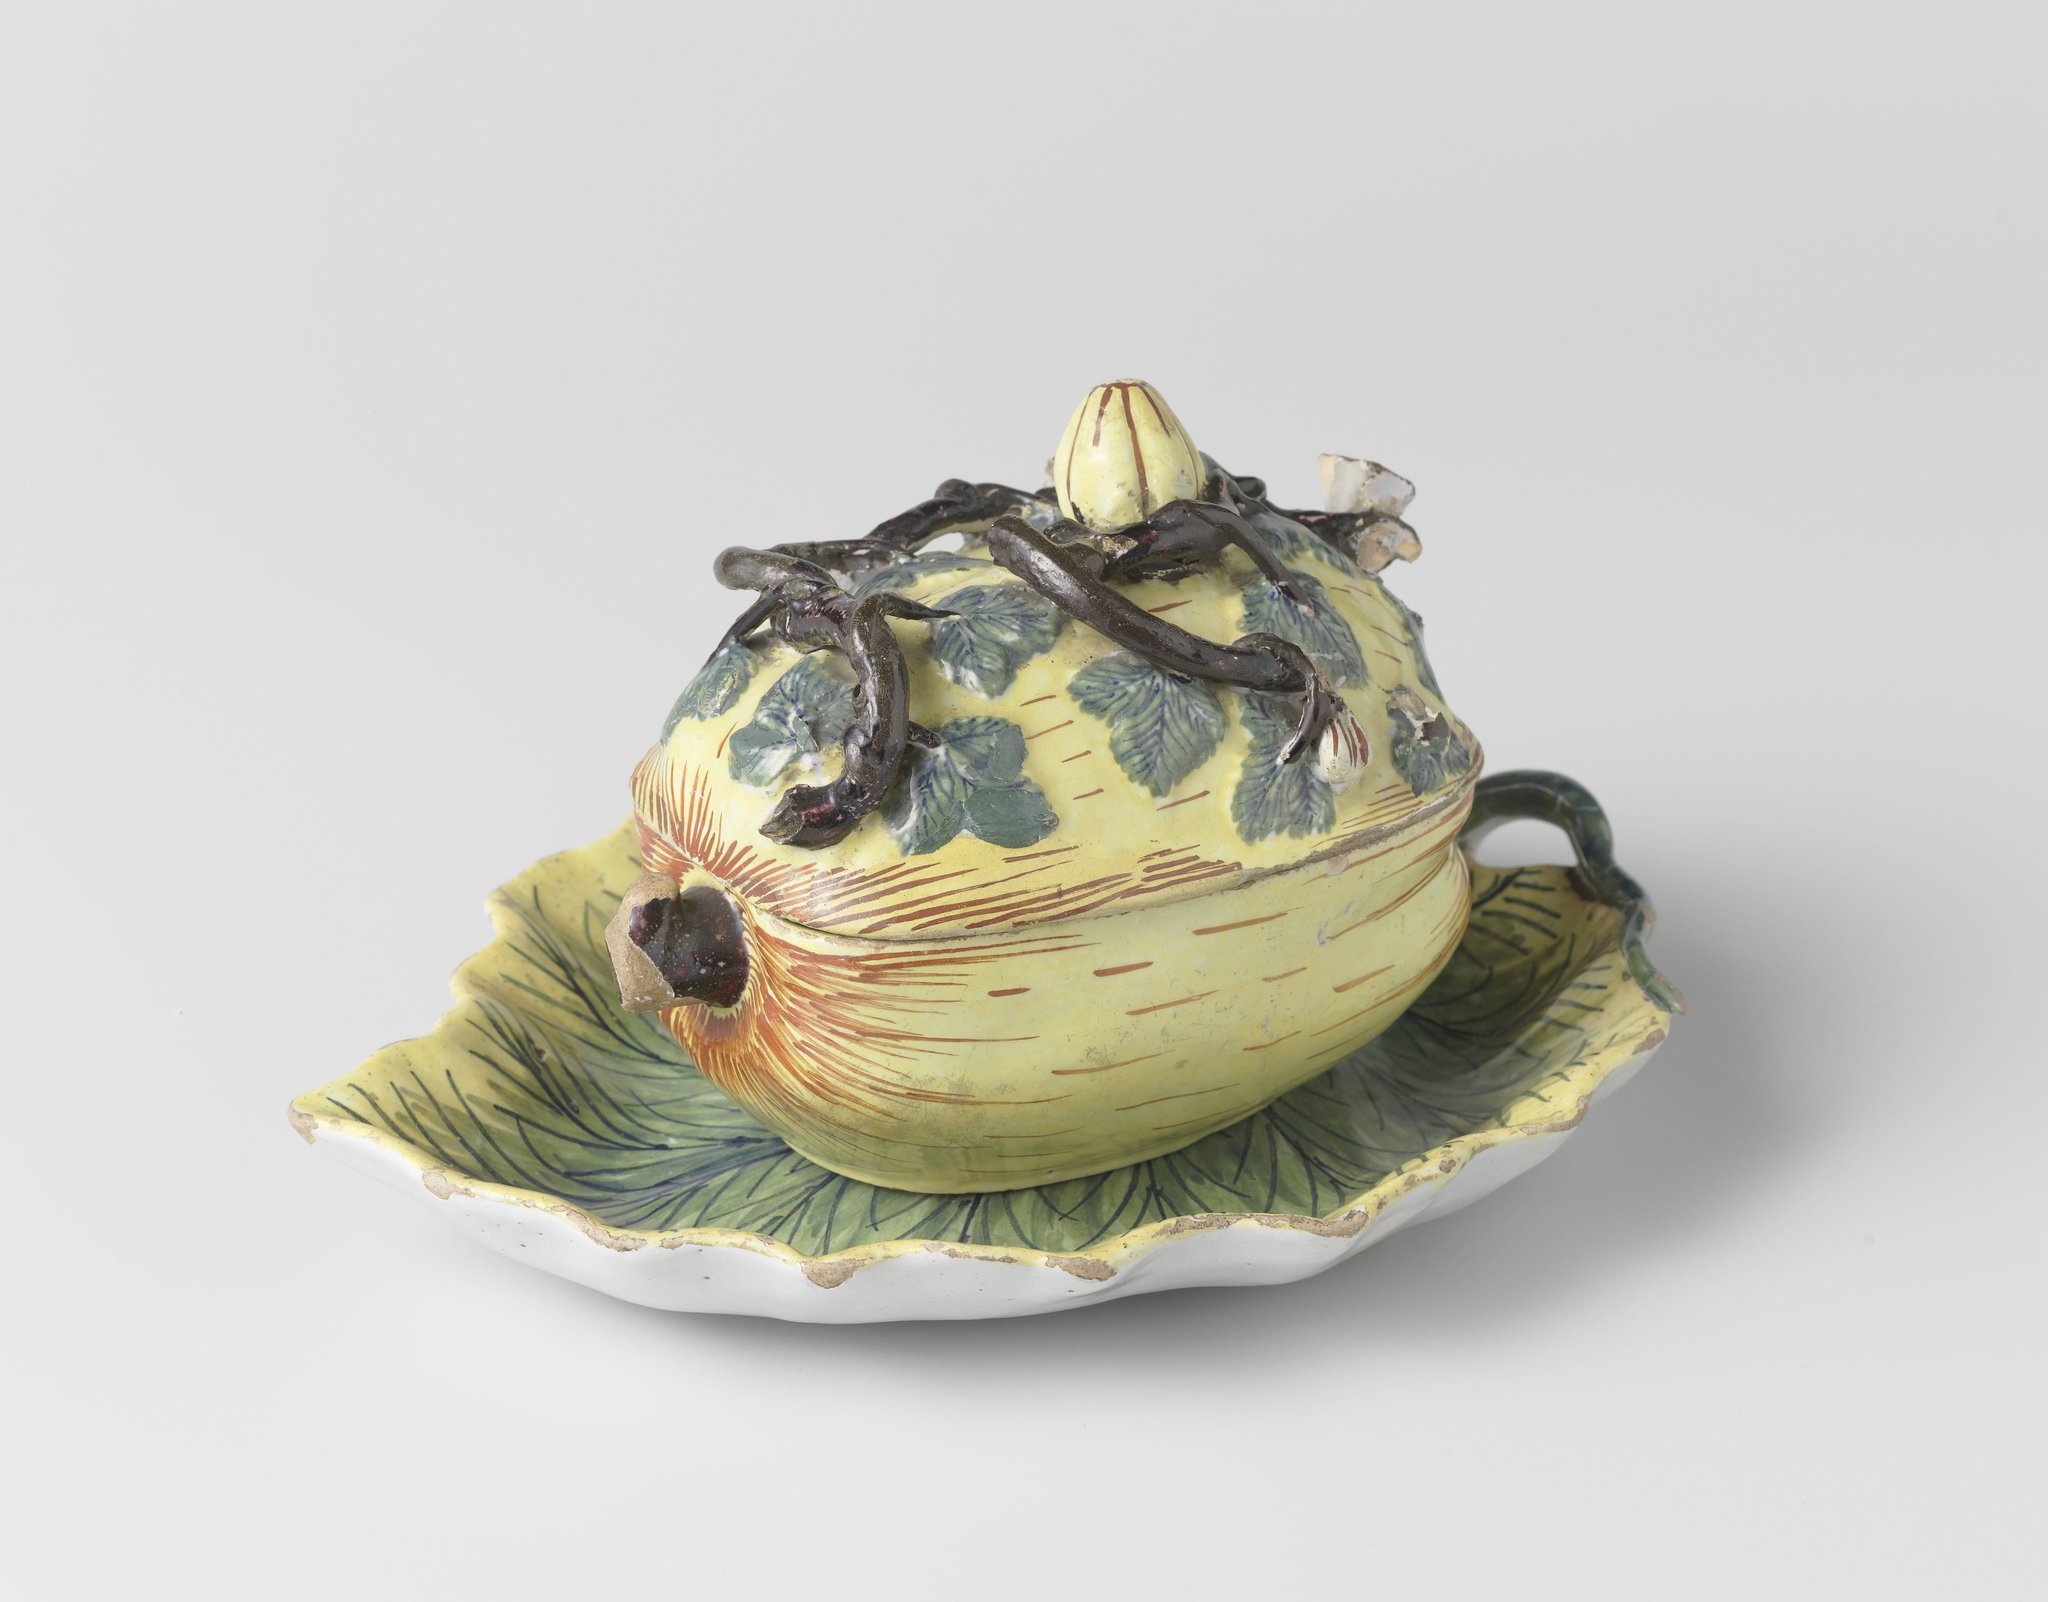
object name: platter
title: Onderschotel van veelkleurig beschilderde faience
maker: hendrik van hoorn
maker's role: eigenaar plateelbakkerij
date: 1759-1804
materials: faience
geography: delft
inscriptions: mark: ‘19’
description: Onderschotel in de vorm van een blad. Horend bij een terrine van aardewerk in de vorm van een pompoen.